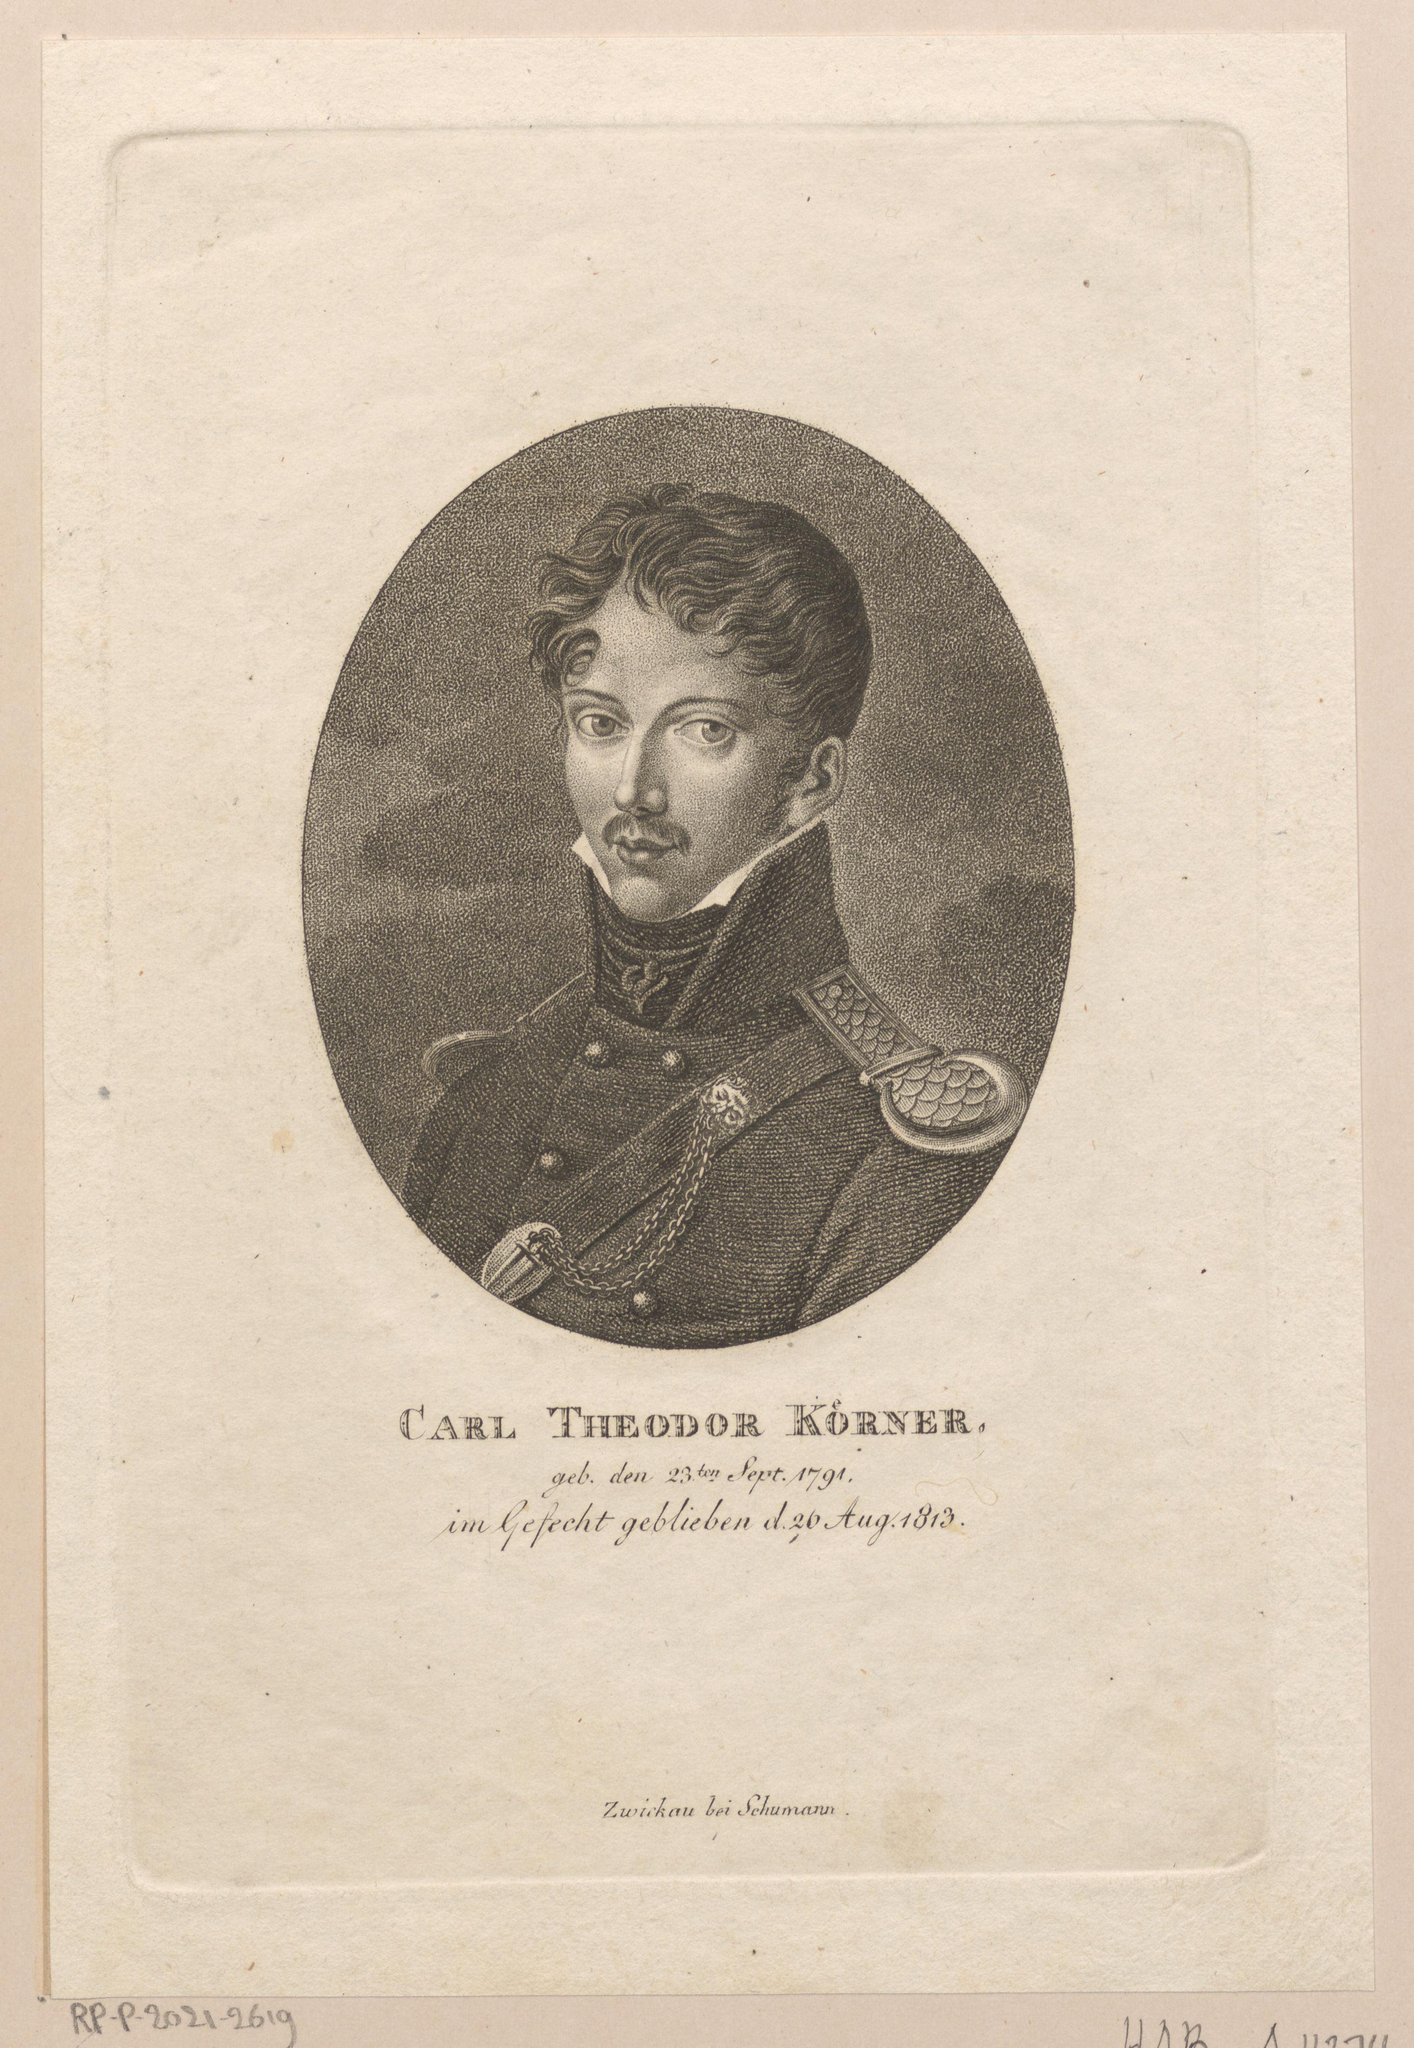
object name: print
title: Portret van Theodor Körner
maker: Anonymous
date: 1813-1826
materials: paper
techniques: etching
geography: zwickau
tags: historical persons